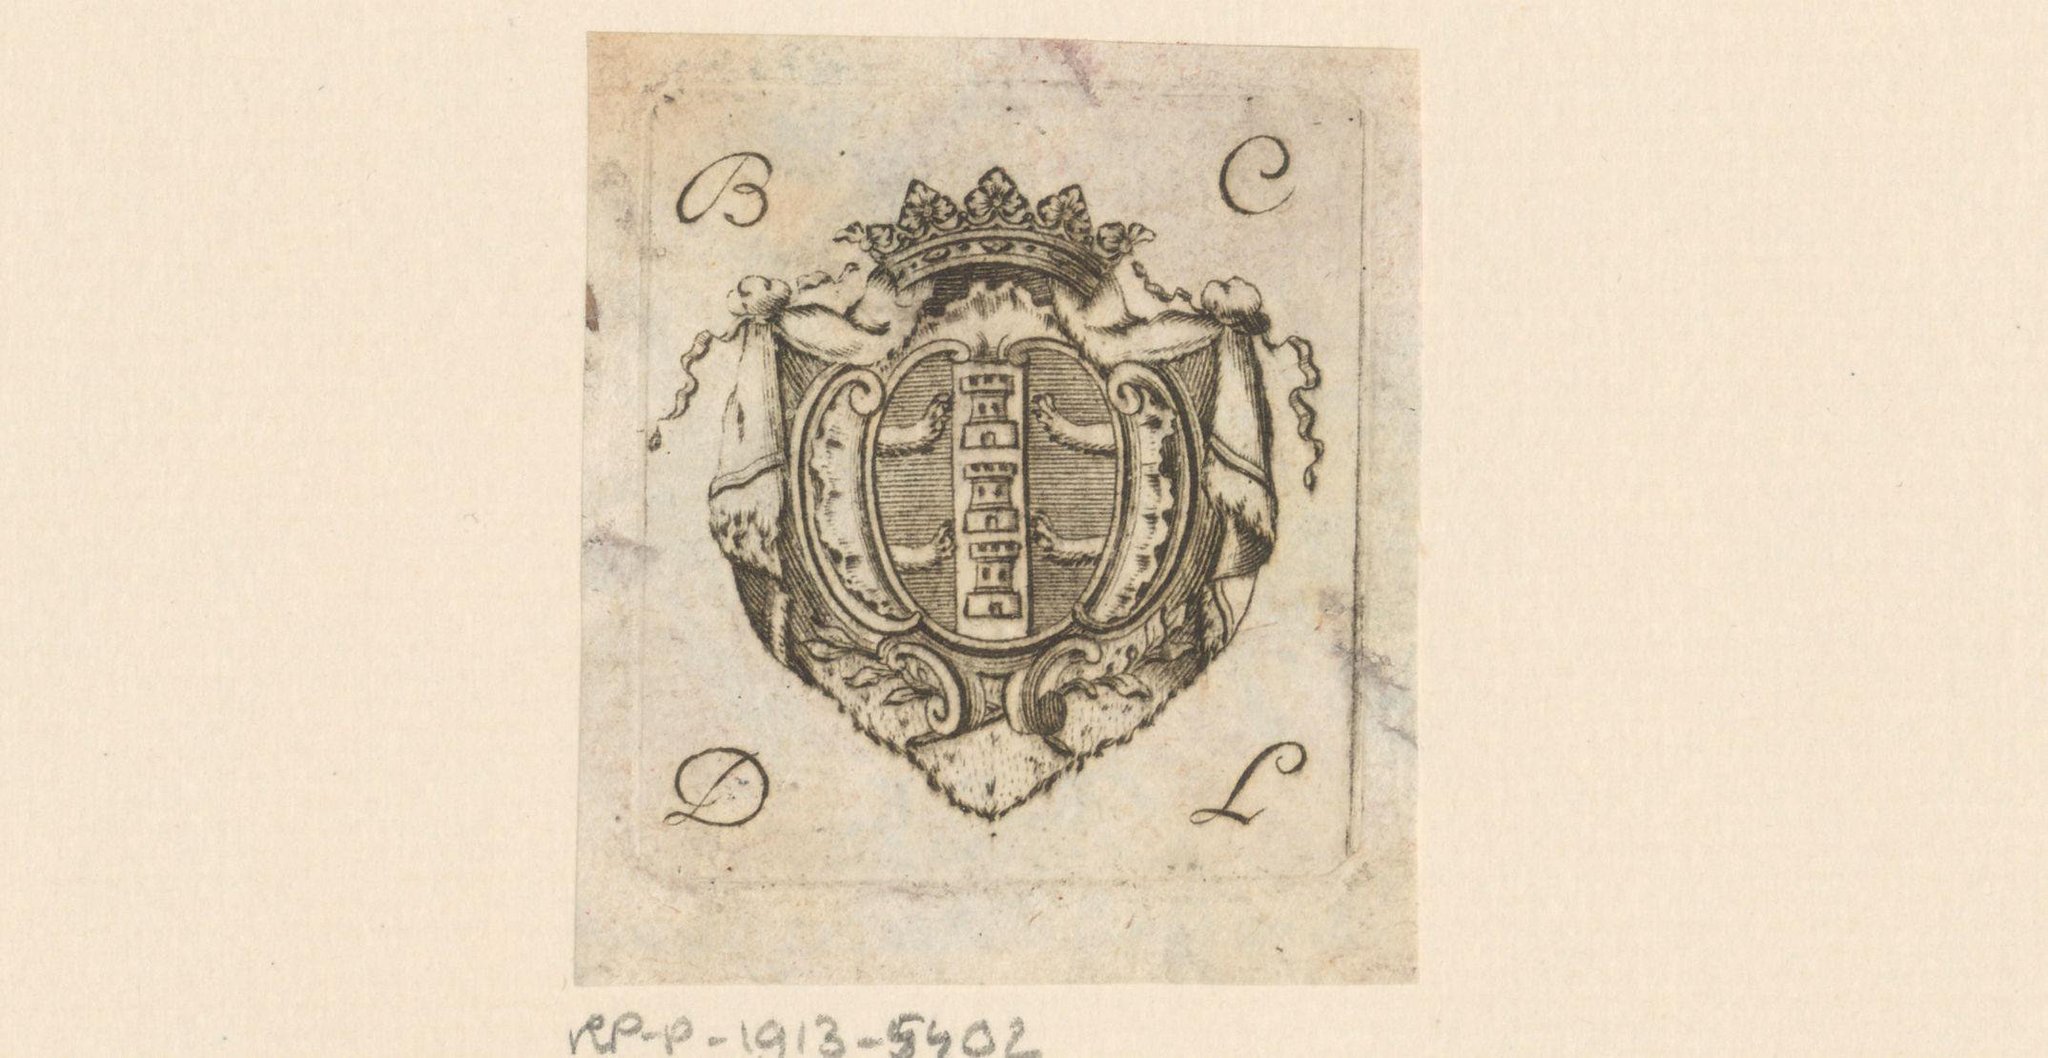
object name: bookplate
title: B.C.D.L.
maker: Anonymous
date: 1743-1824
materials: paper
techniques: engraving, etching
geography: france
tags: tower, clock tower ~ monumental adornment, armorial bearing, heraldry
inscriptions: collector's mark: Lugt 2760, collector's mark: Lugt 2233